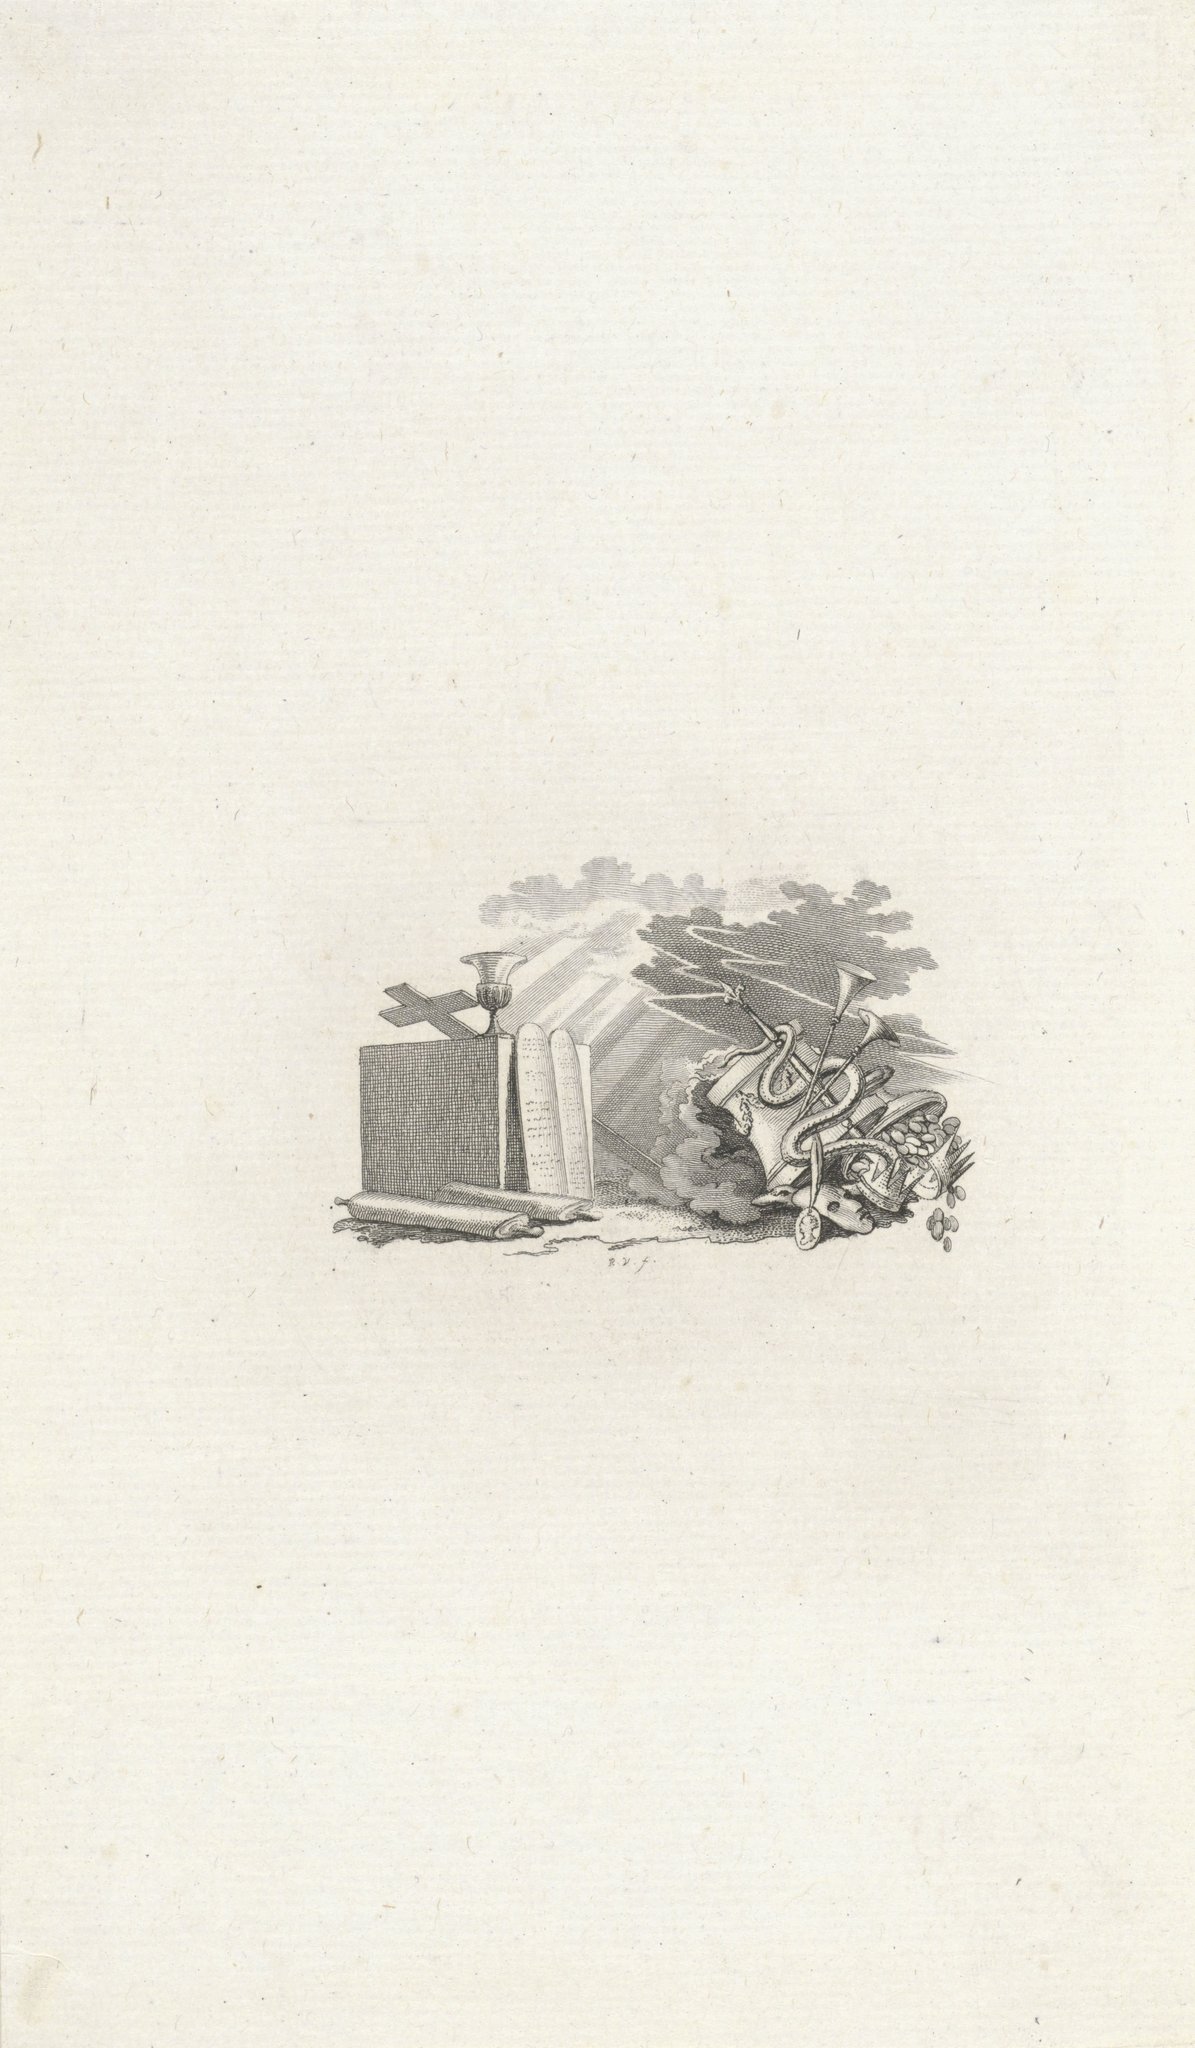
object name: print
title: Vignet met symbolen van eeuwigheid en vergankelijkheid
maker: reinier vinkeles (i)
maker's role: draughtsman, print maker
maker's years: 1741-1816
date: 1751-1816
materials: paper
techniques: etching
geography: amsterdam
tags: scenes symbolizing 'vanitas', allegorical representations of the effects of time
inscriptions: collector's mark: Lugt 240